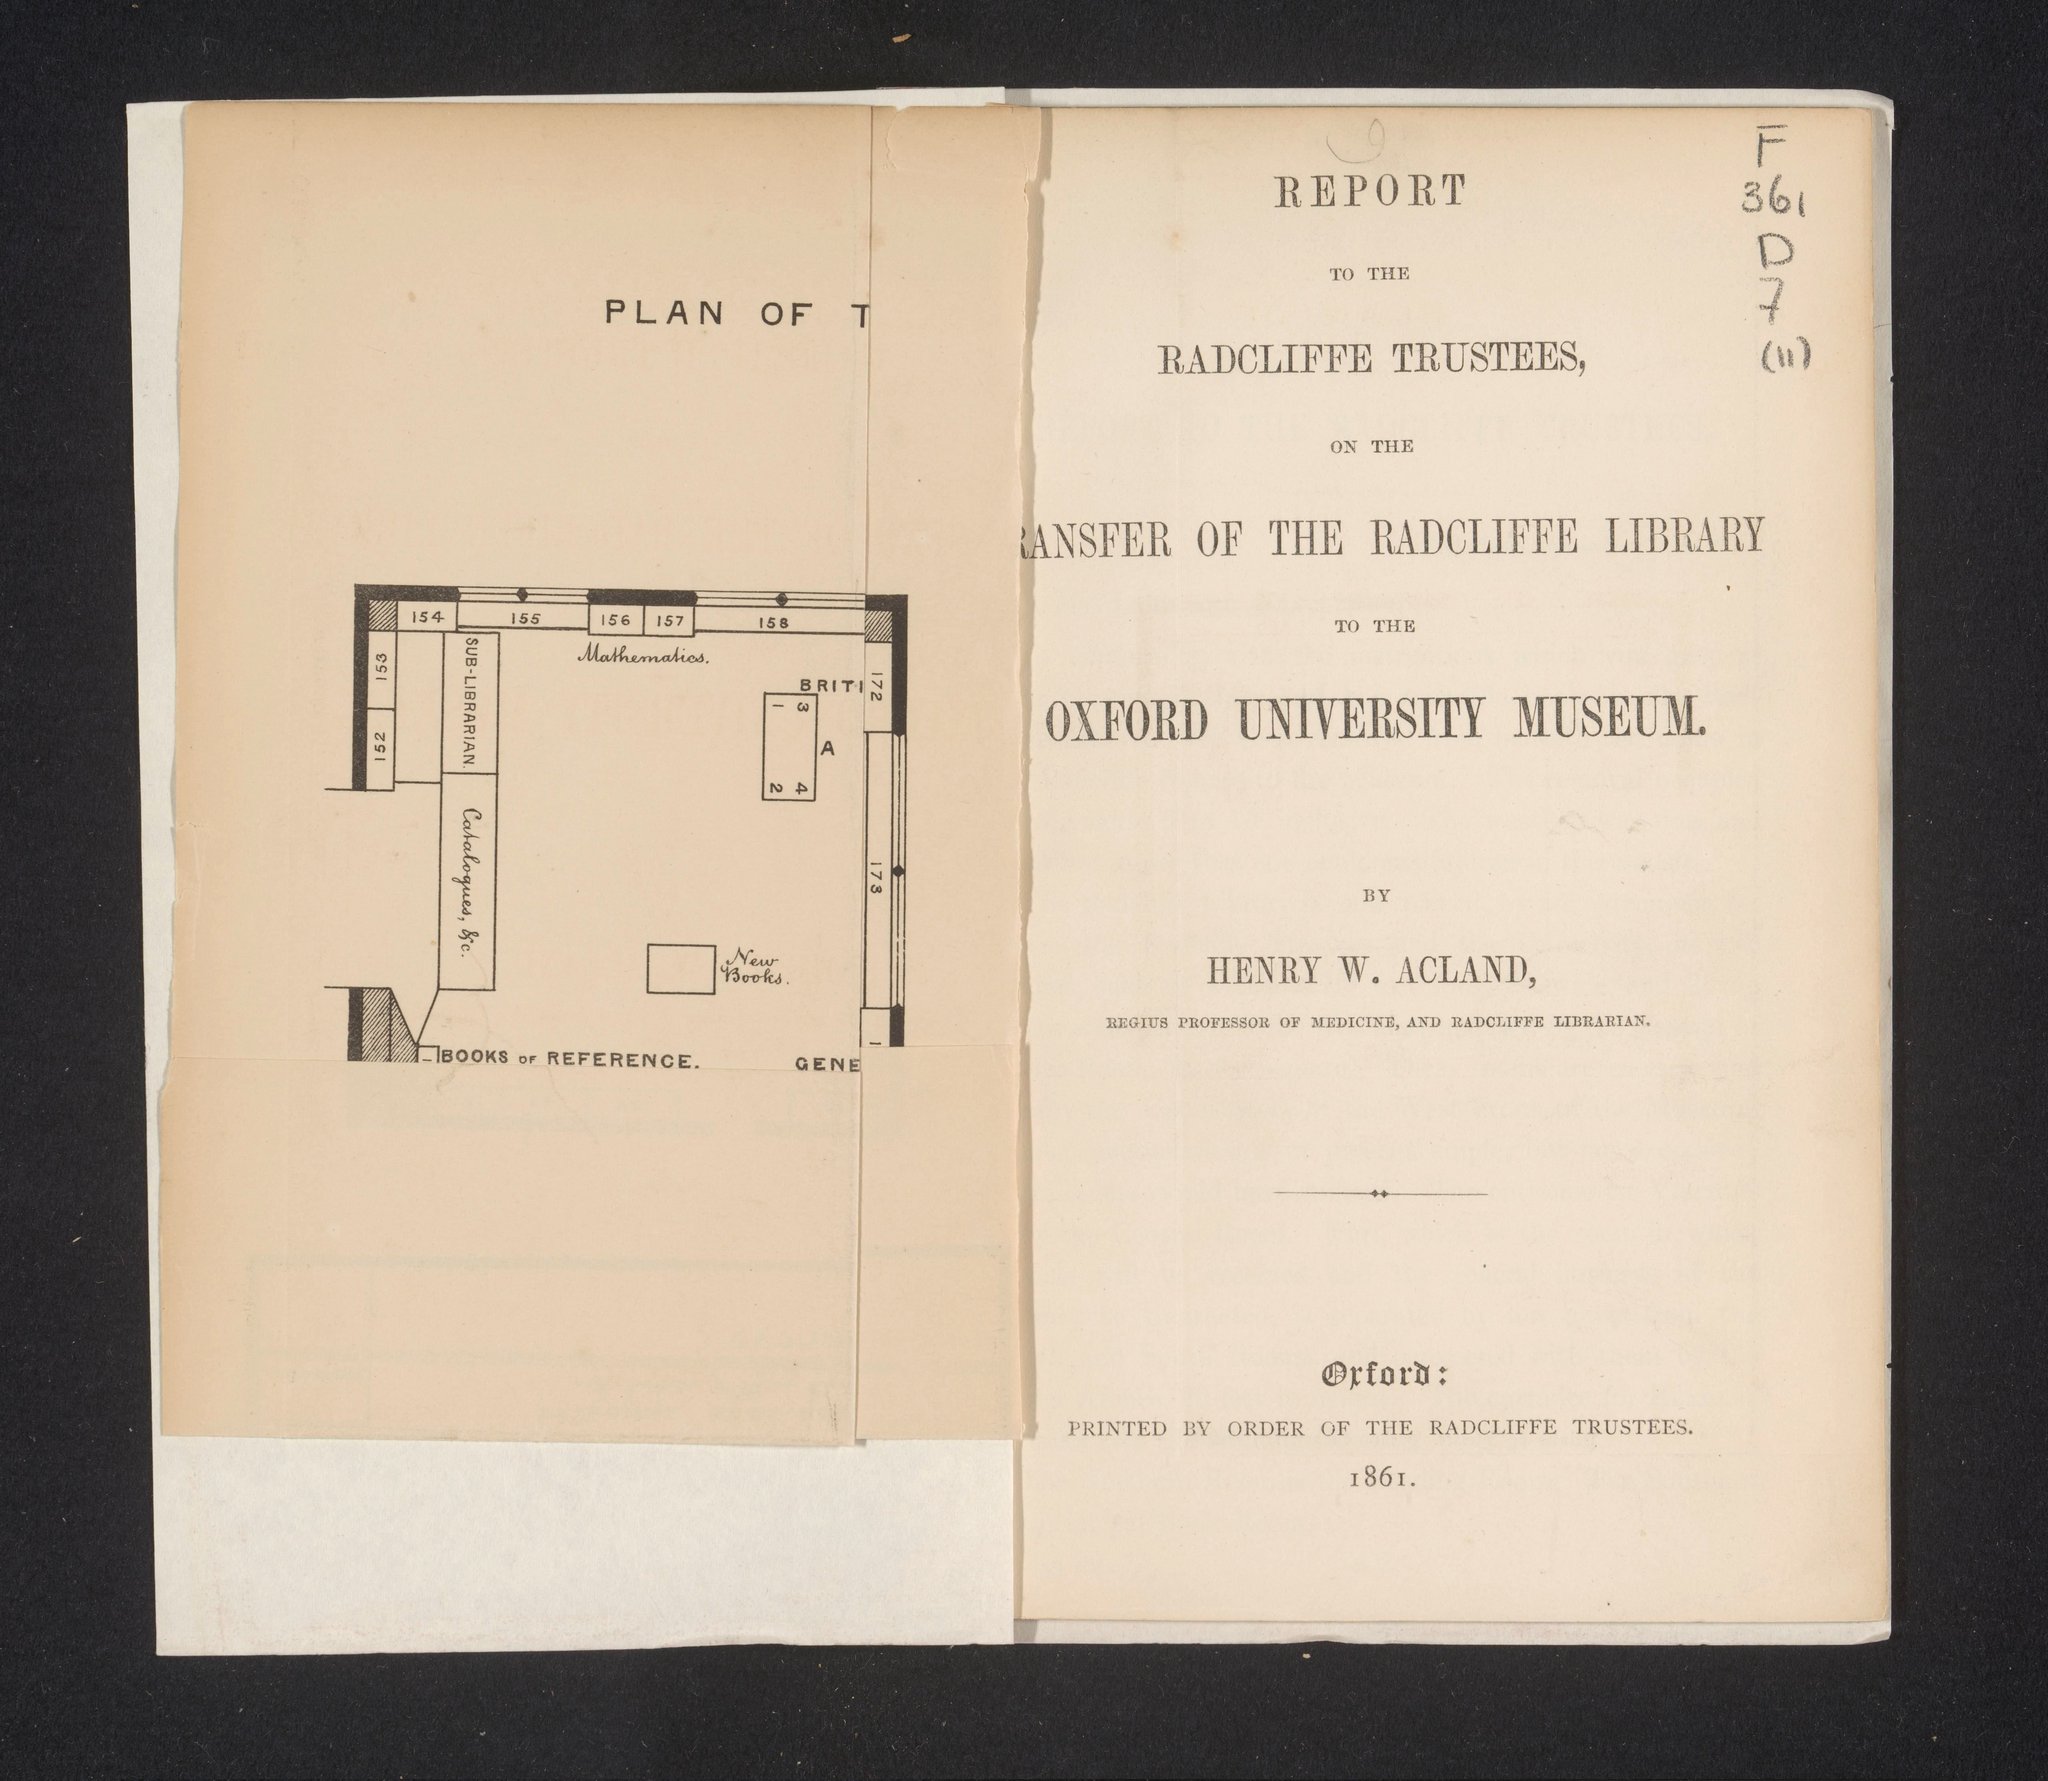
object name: book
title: Report to the Radcliffe trustees, on the transfer of the Radcliffe Library to the Oxford University Museum / by Henry W. Acland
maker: henry w. acland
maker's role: arts, bibliothecaris, professor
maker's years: 1815-1900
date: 1861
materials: paper, photographic support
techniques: albumen print, marbled paper, lithograph, printing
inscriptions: annotation: ‘Mounted/ photograph/ £35’, date: ‘APR/ 1997’